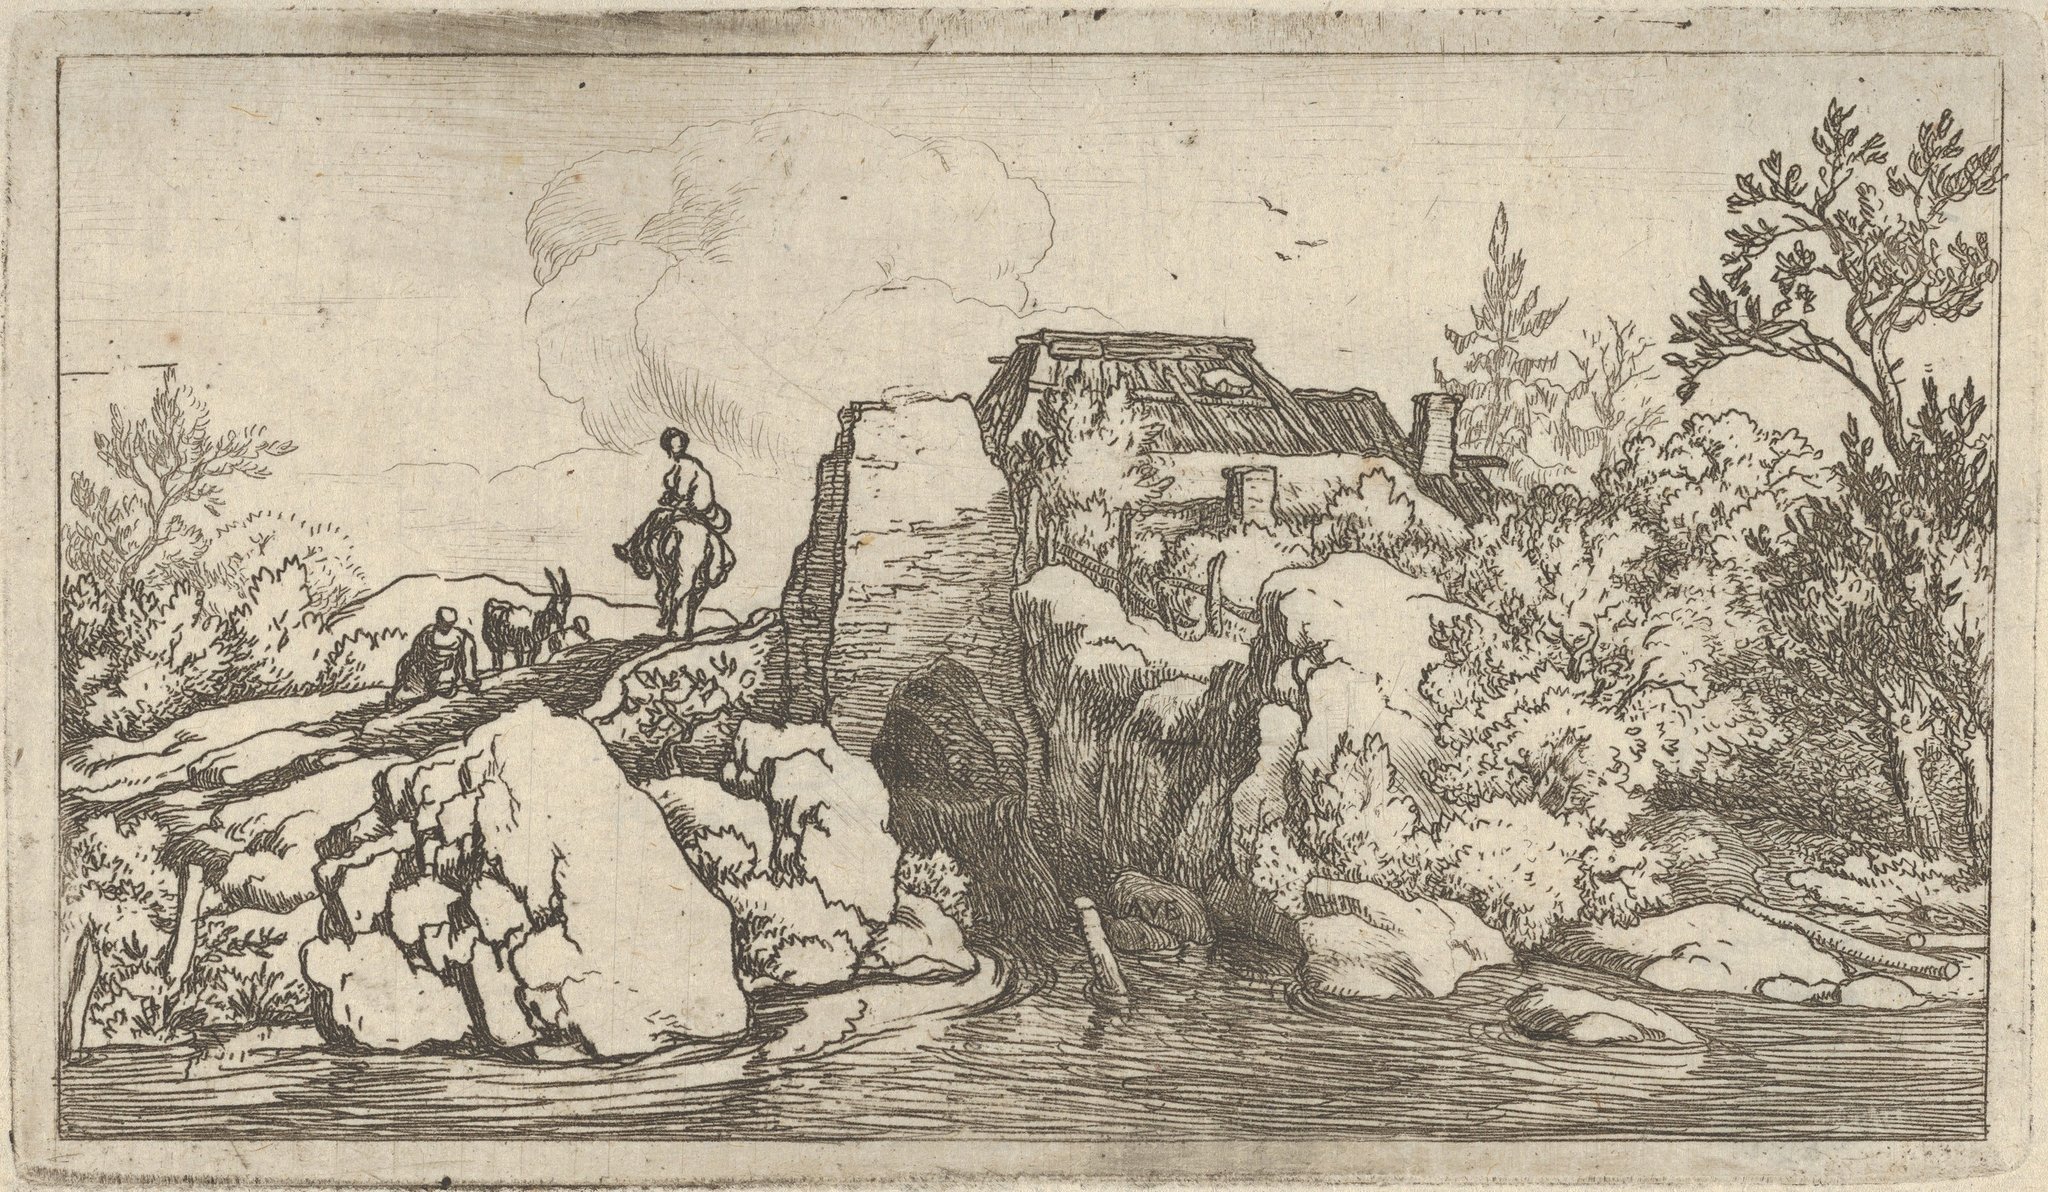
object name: print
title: The Horseman on the Stone Bridge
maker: allart van everdingen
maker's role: artist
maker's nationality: dutch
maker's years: 1621-1675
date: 1621-1675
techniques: engraving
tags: bridges,men,horses